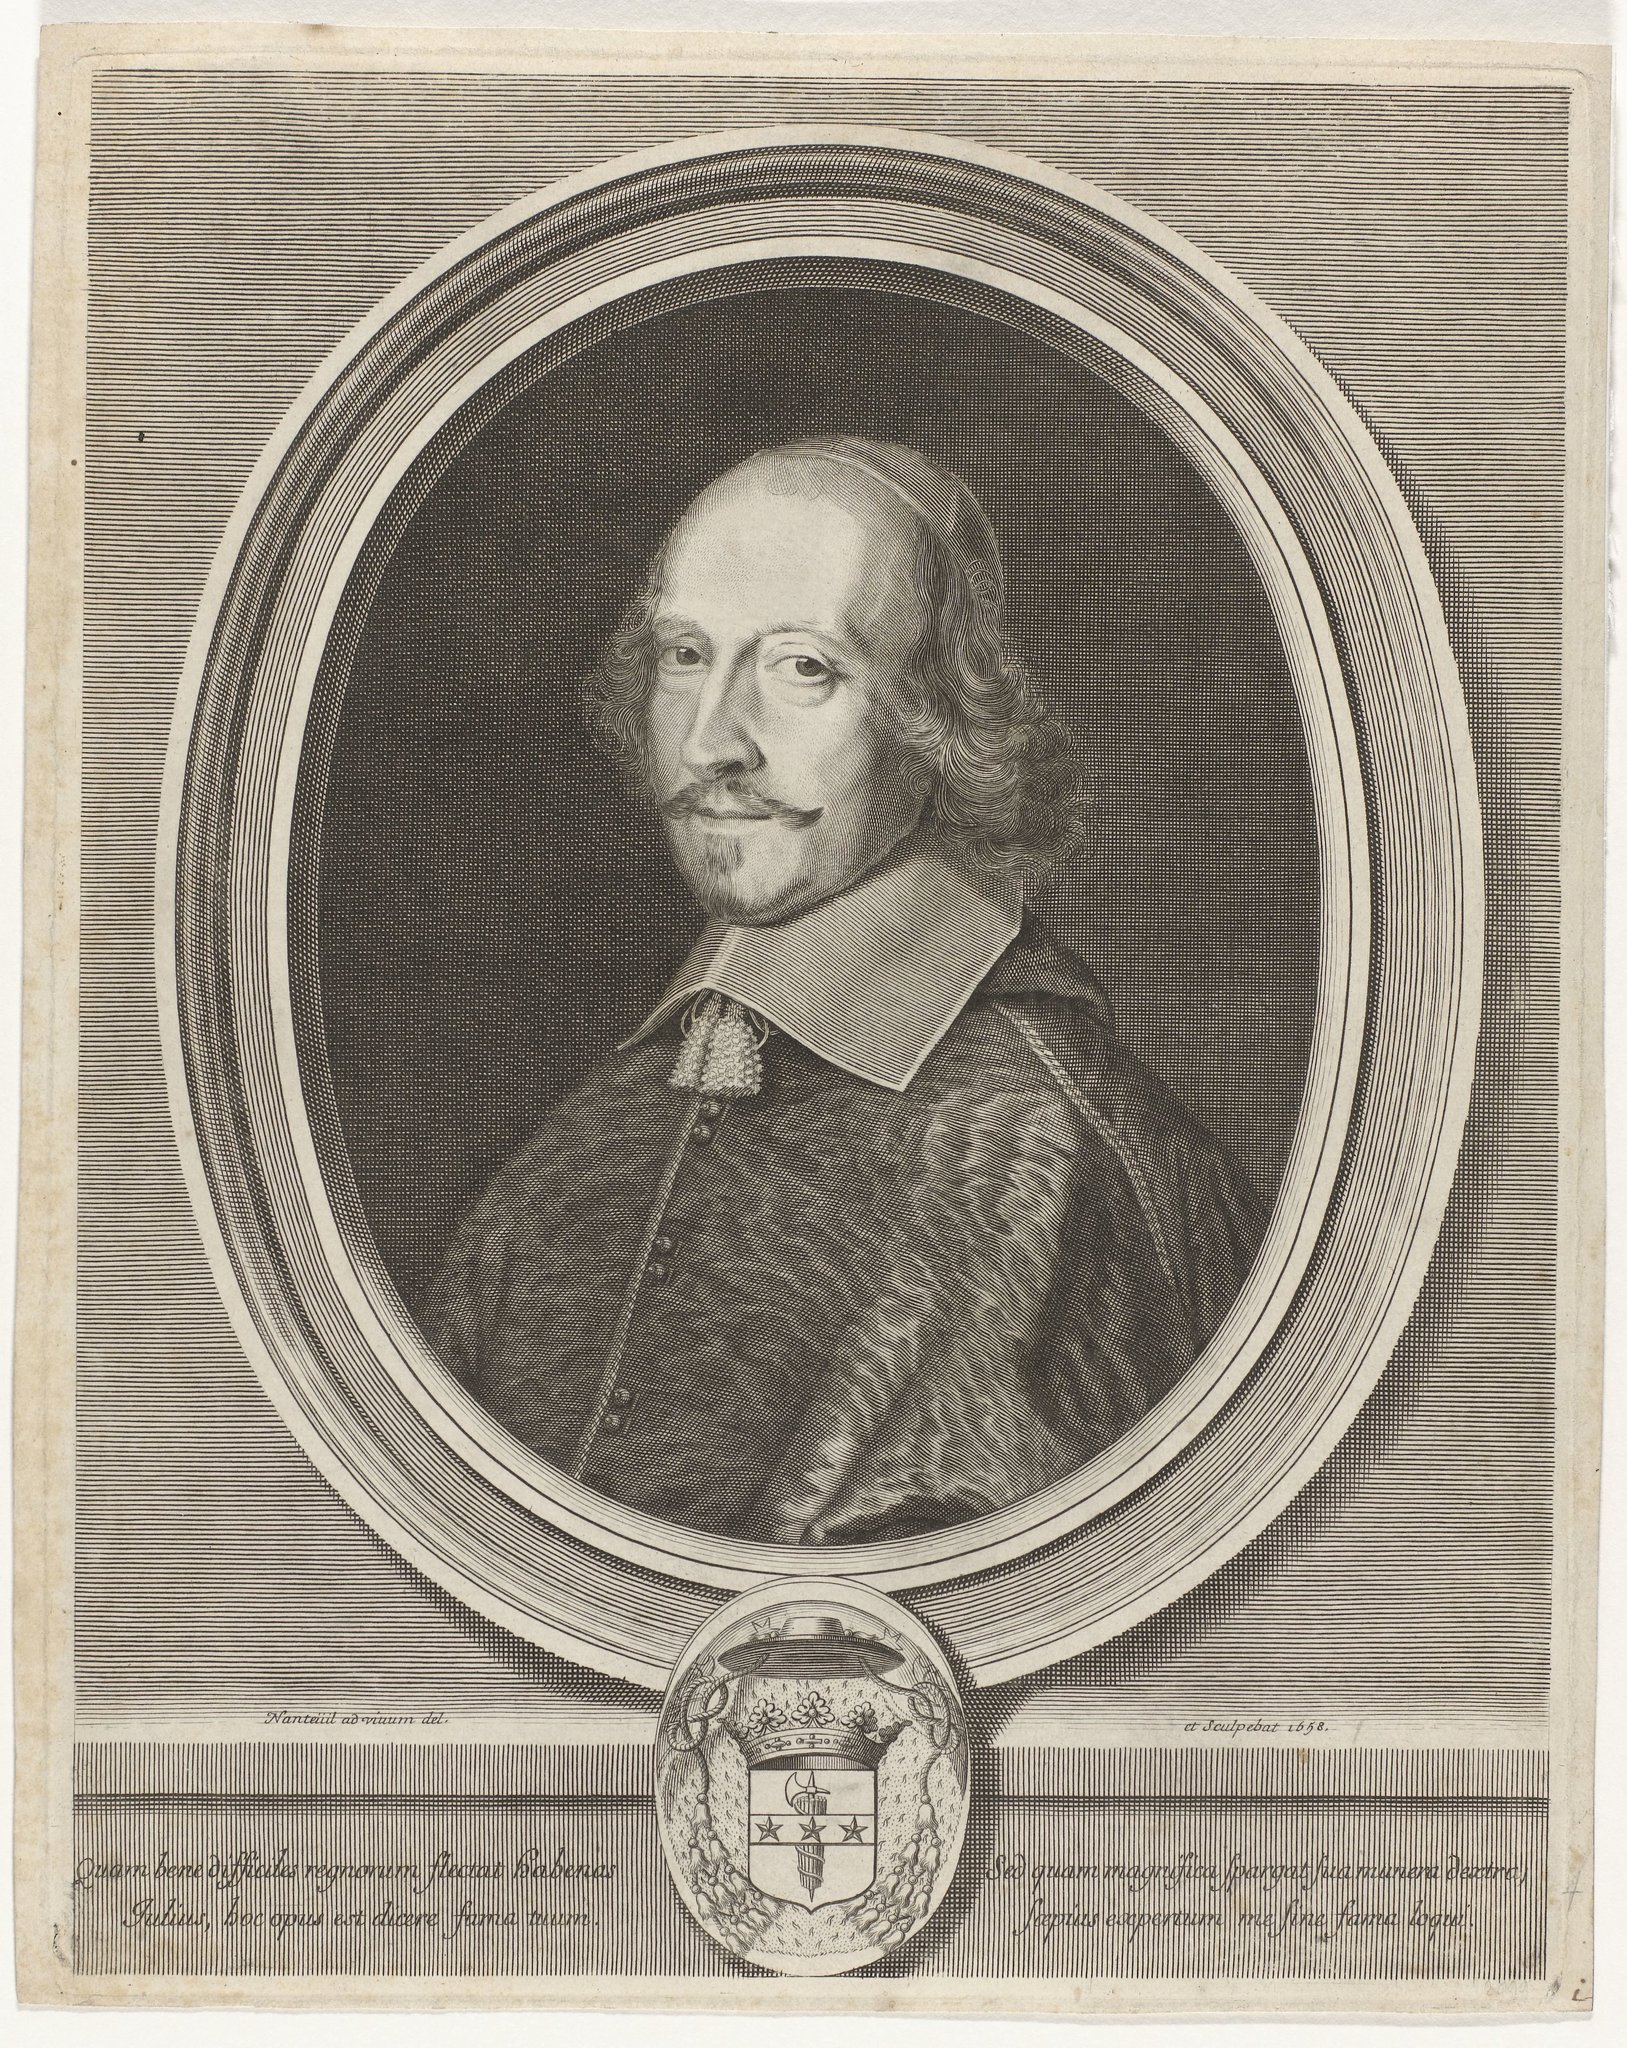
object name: print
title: Portret kardinaal Mazarin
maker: robert nanteuil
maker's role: print maker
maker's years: 1623-1678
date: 1658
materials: paper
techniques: engraving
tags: jules mazarin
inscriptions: caption: ‘Quam bene difficiles...sine fama loqui.’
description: Buste naar links, in ovale lijst met middenonder zijn wapen. De lijst staat op een sokkel waarop onderschrift in Latijn: Quam bene difficiles...sine fama loqui.